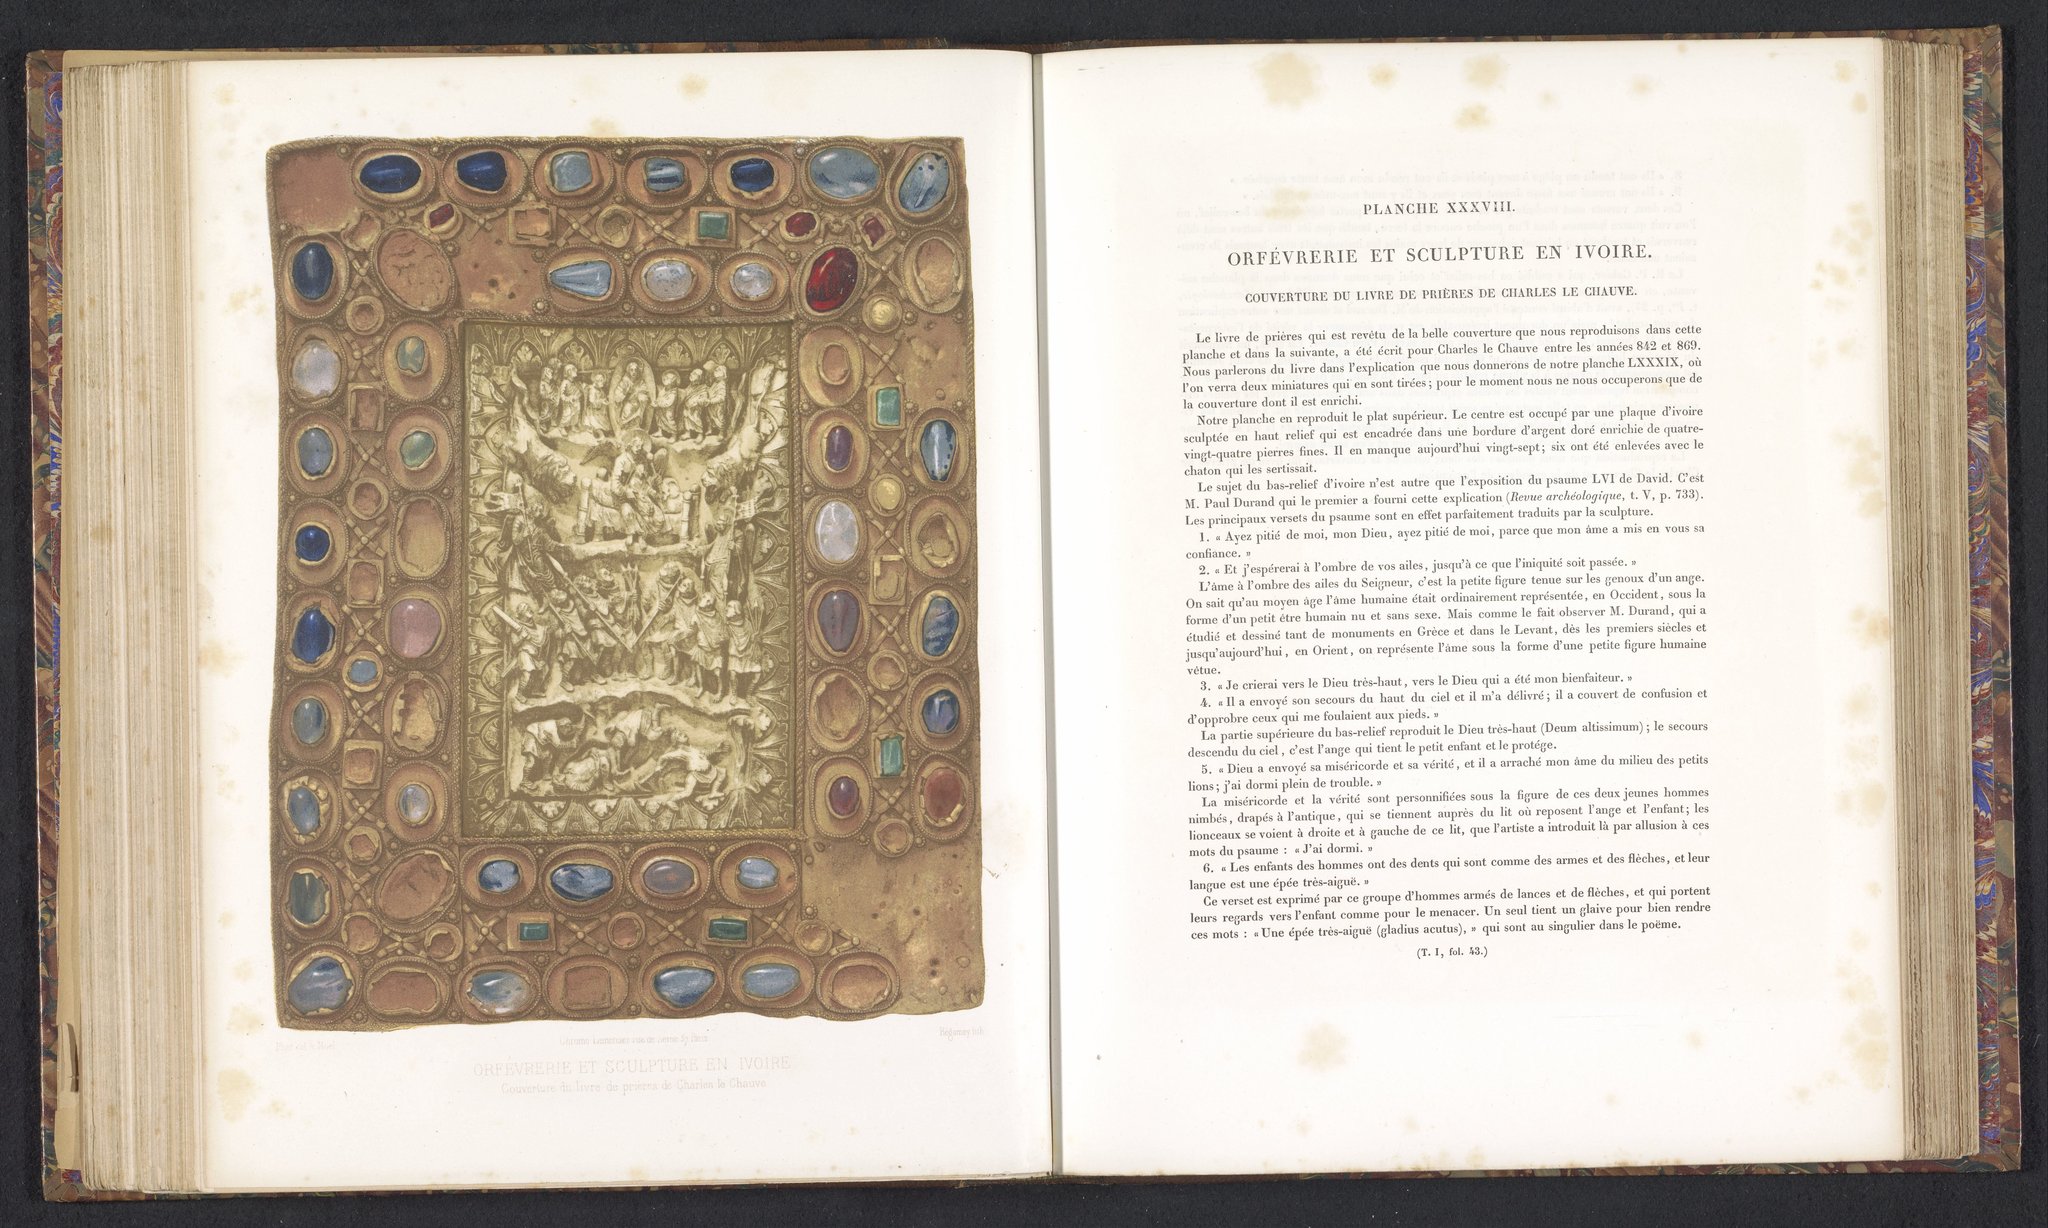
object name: page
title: Orfévrerie et sculpture en ivoire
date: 1859-1864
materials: paper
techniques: chromolithography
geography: paris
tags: book-cover, binding, gem, gemstone